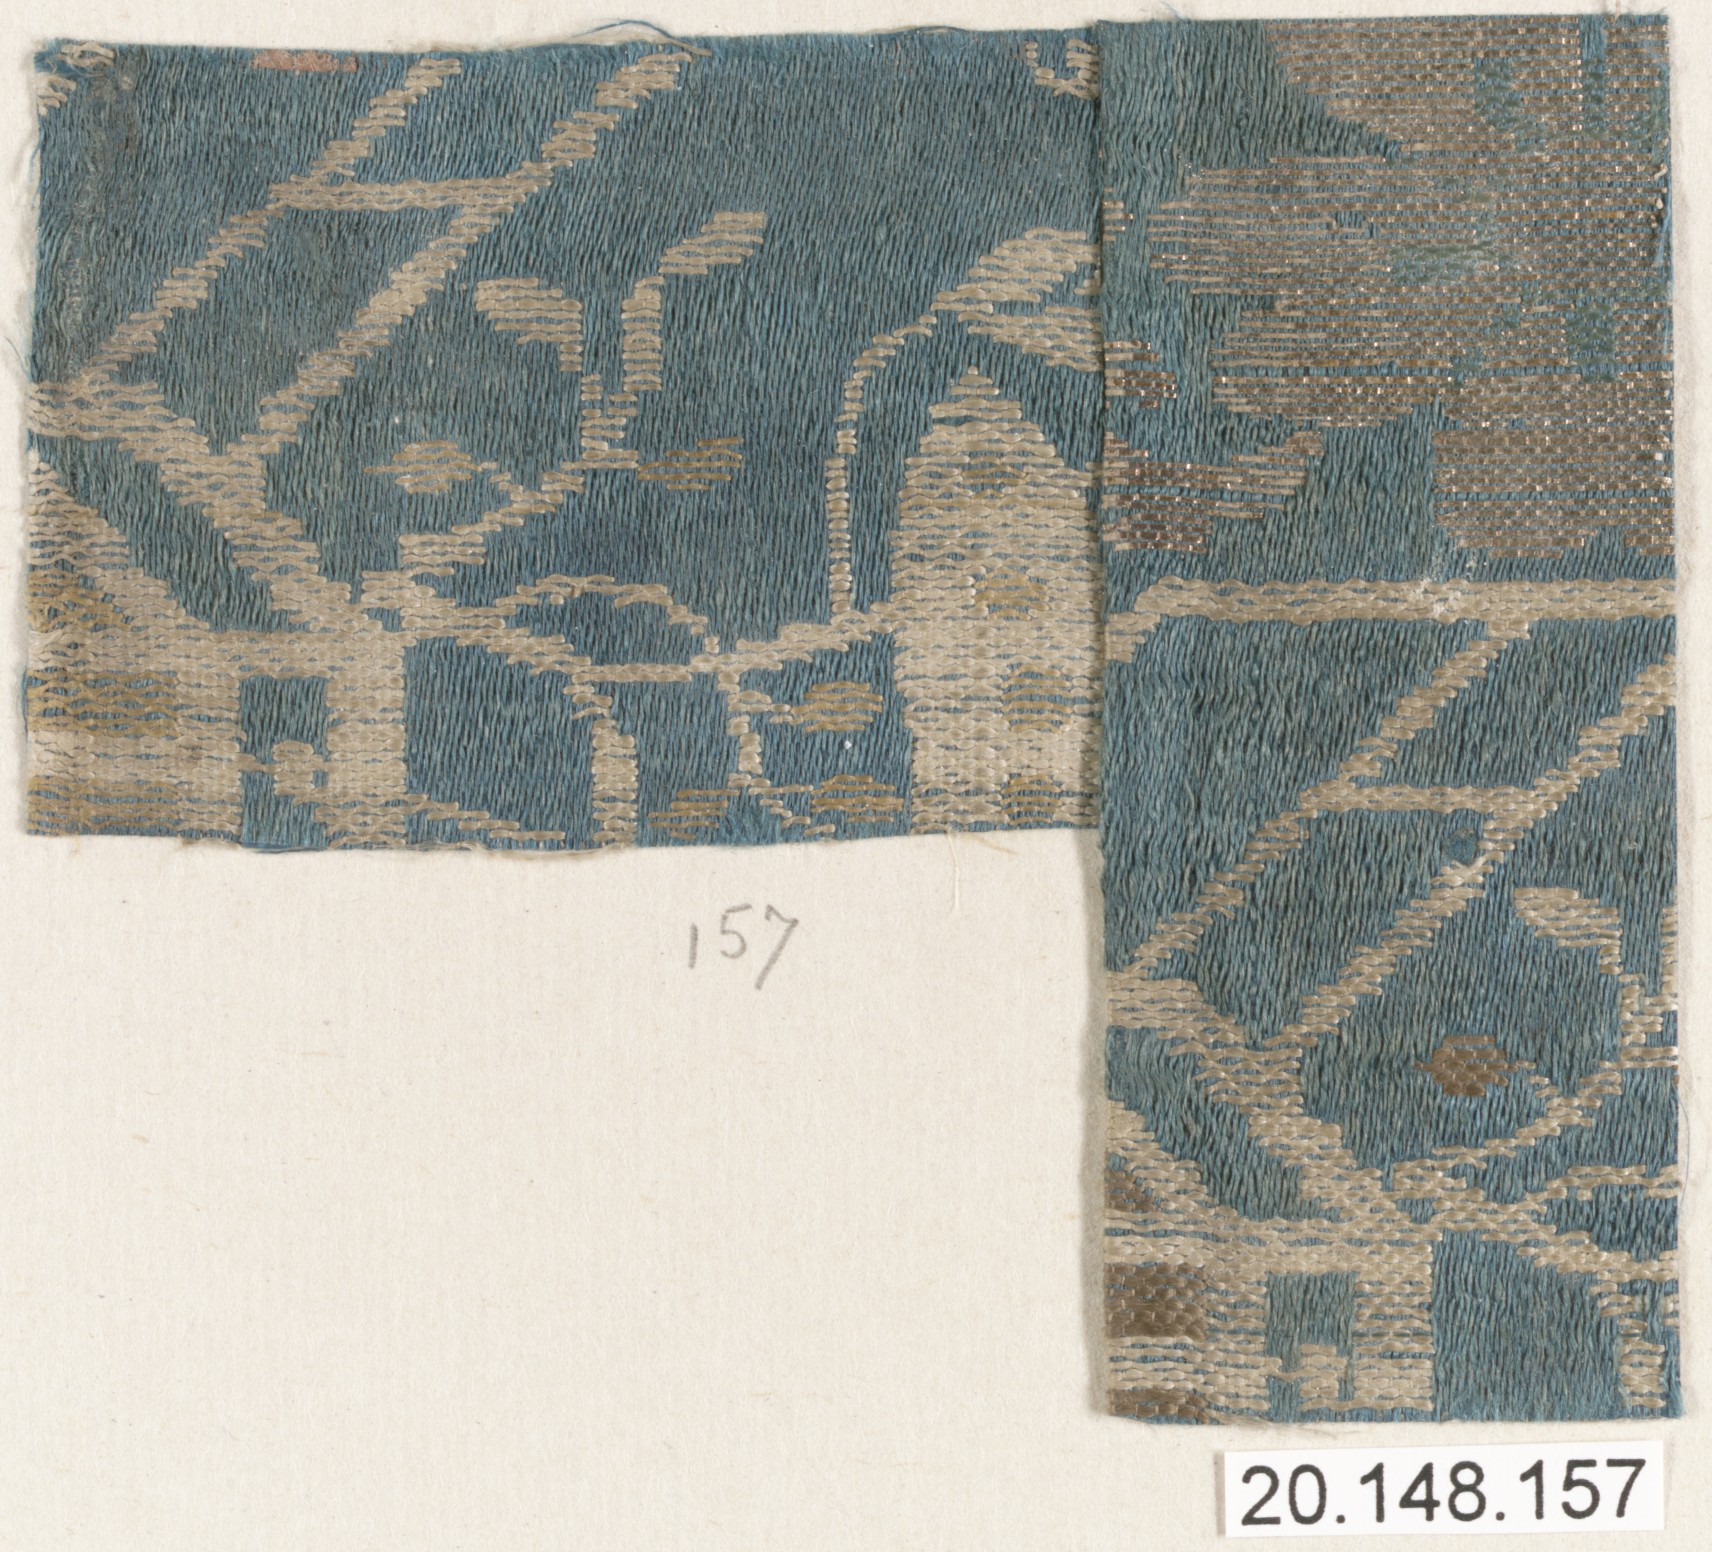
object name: piece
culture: japanese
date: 1601-1700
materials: silk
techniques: compound weave